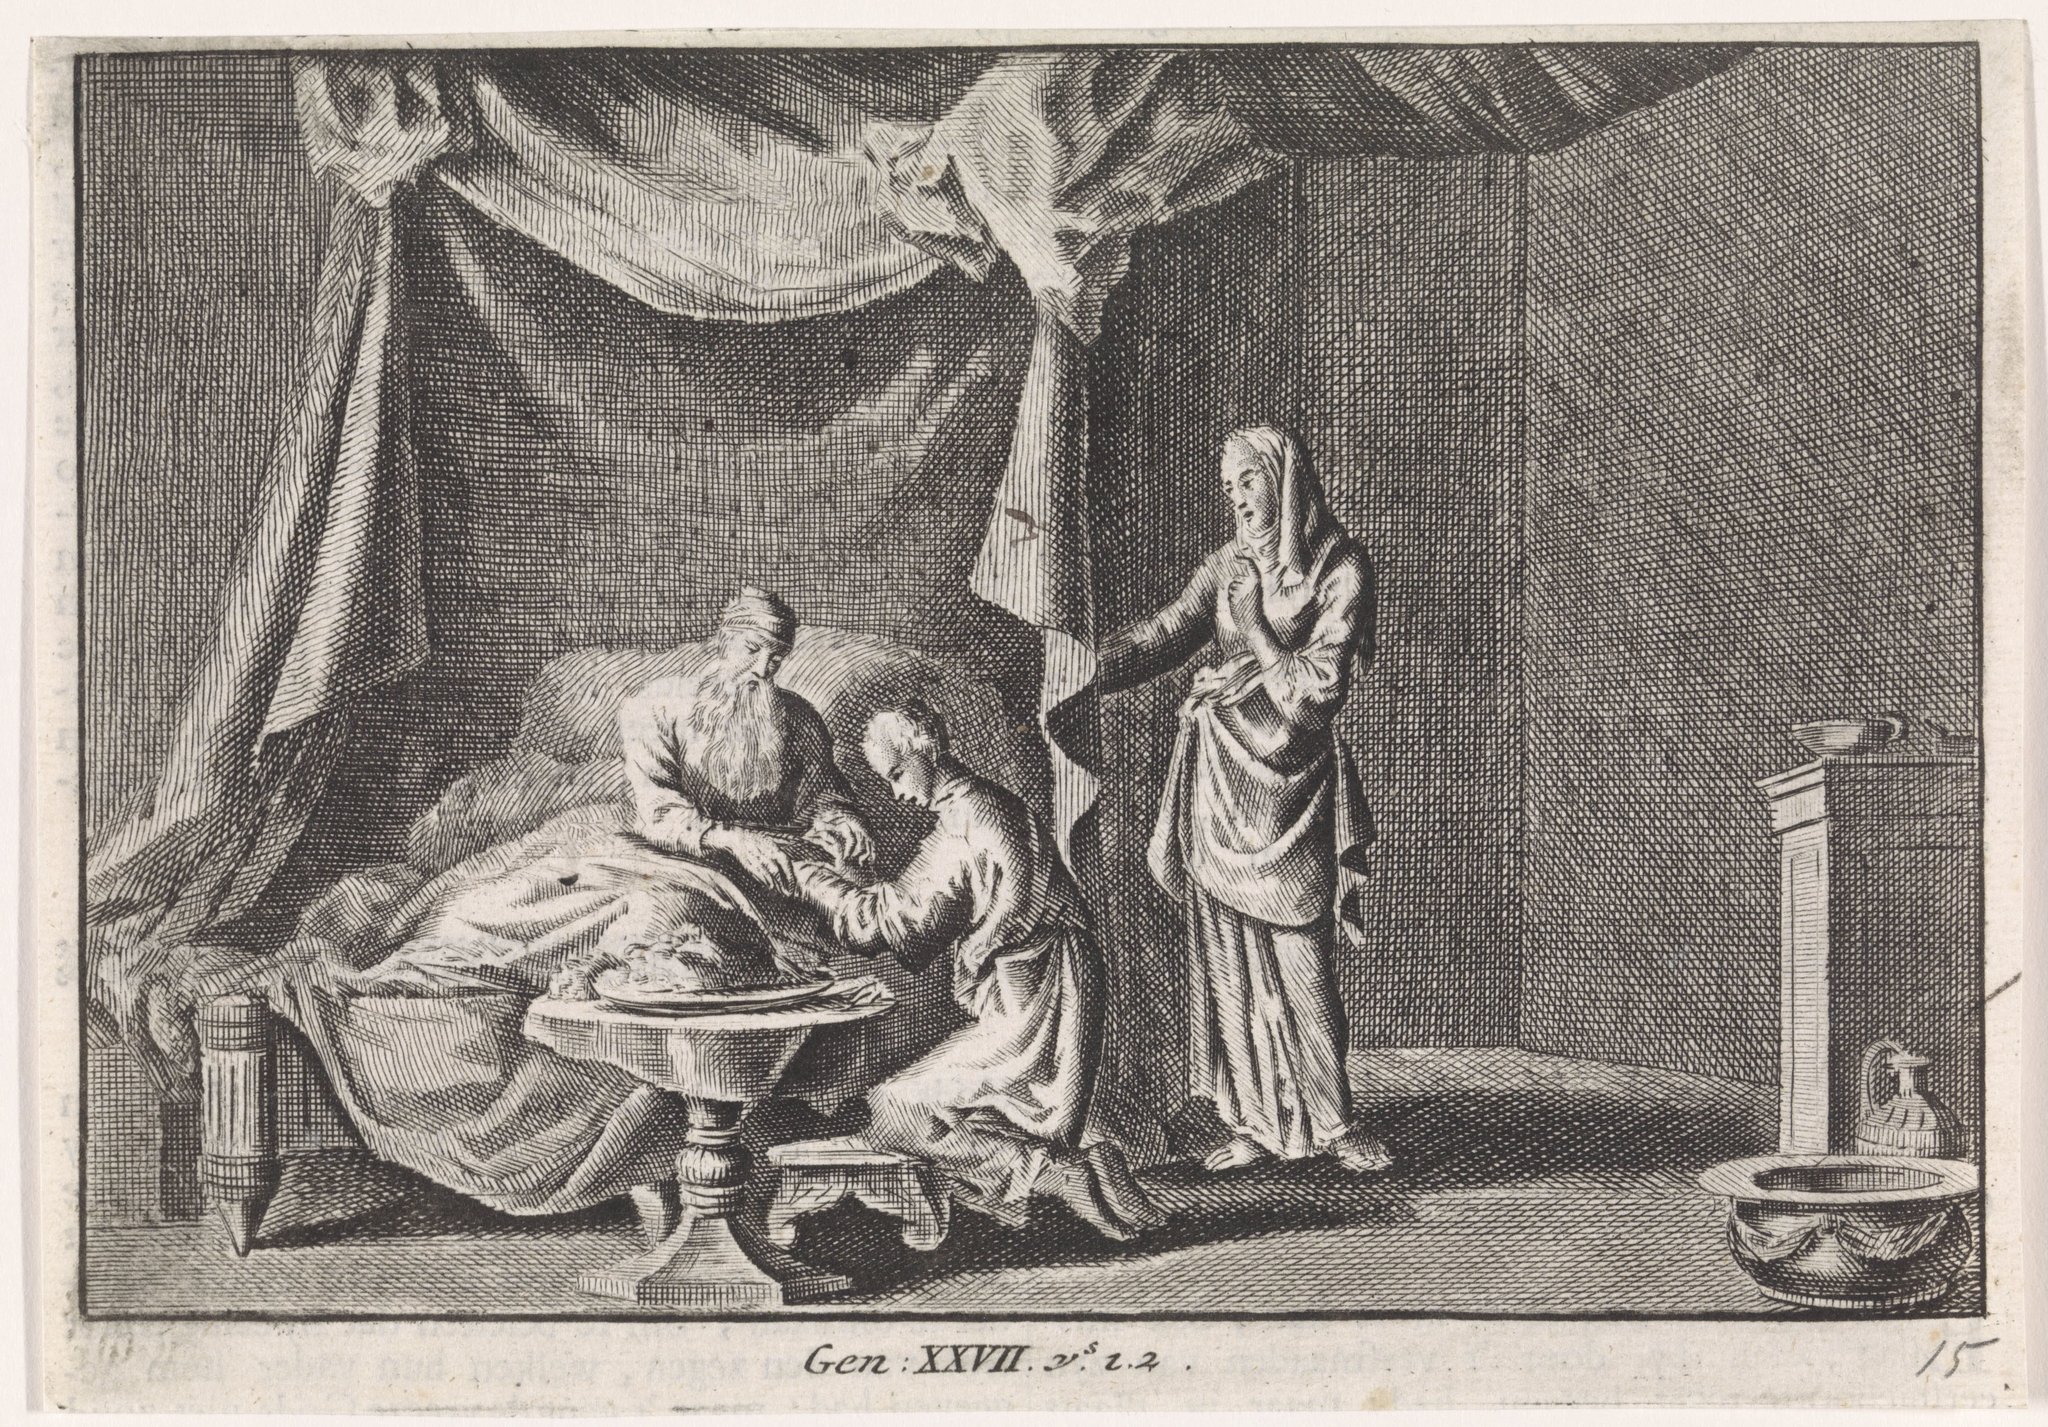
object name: book illustration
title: Isaak zegent Jakob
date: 1703-1762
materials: paper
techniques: etching, letterpress printing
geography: haarlem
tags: isaac lying in bed blesses jacob who, disguised in esau's clothes, brings food to his father; jacob's hands and neck are covered with goatskins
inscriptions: collector's mark: Lugt 2228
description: De prent komt een eerste keer voor als boekillustratie voor David Martin. Historie des Ouden en Nieuwen Testaments. Amsterdam, Pieter Mortier, 1703. Deel I. De boekillustraties voor de Mortierbijbel hebben verschillende staten en kopieën, waarbij de chronologische volgorde moeilijk te achterhalen valt. Als boekillustraties werden ze bovendien herhaaldelijk opnieuw gebruikt voor andere boekwerken.